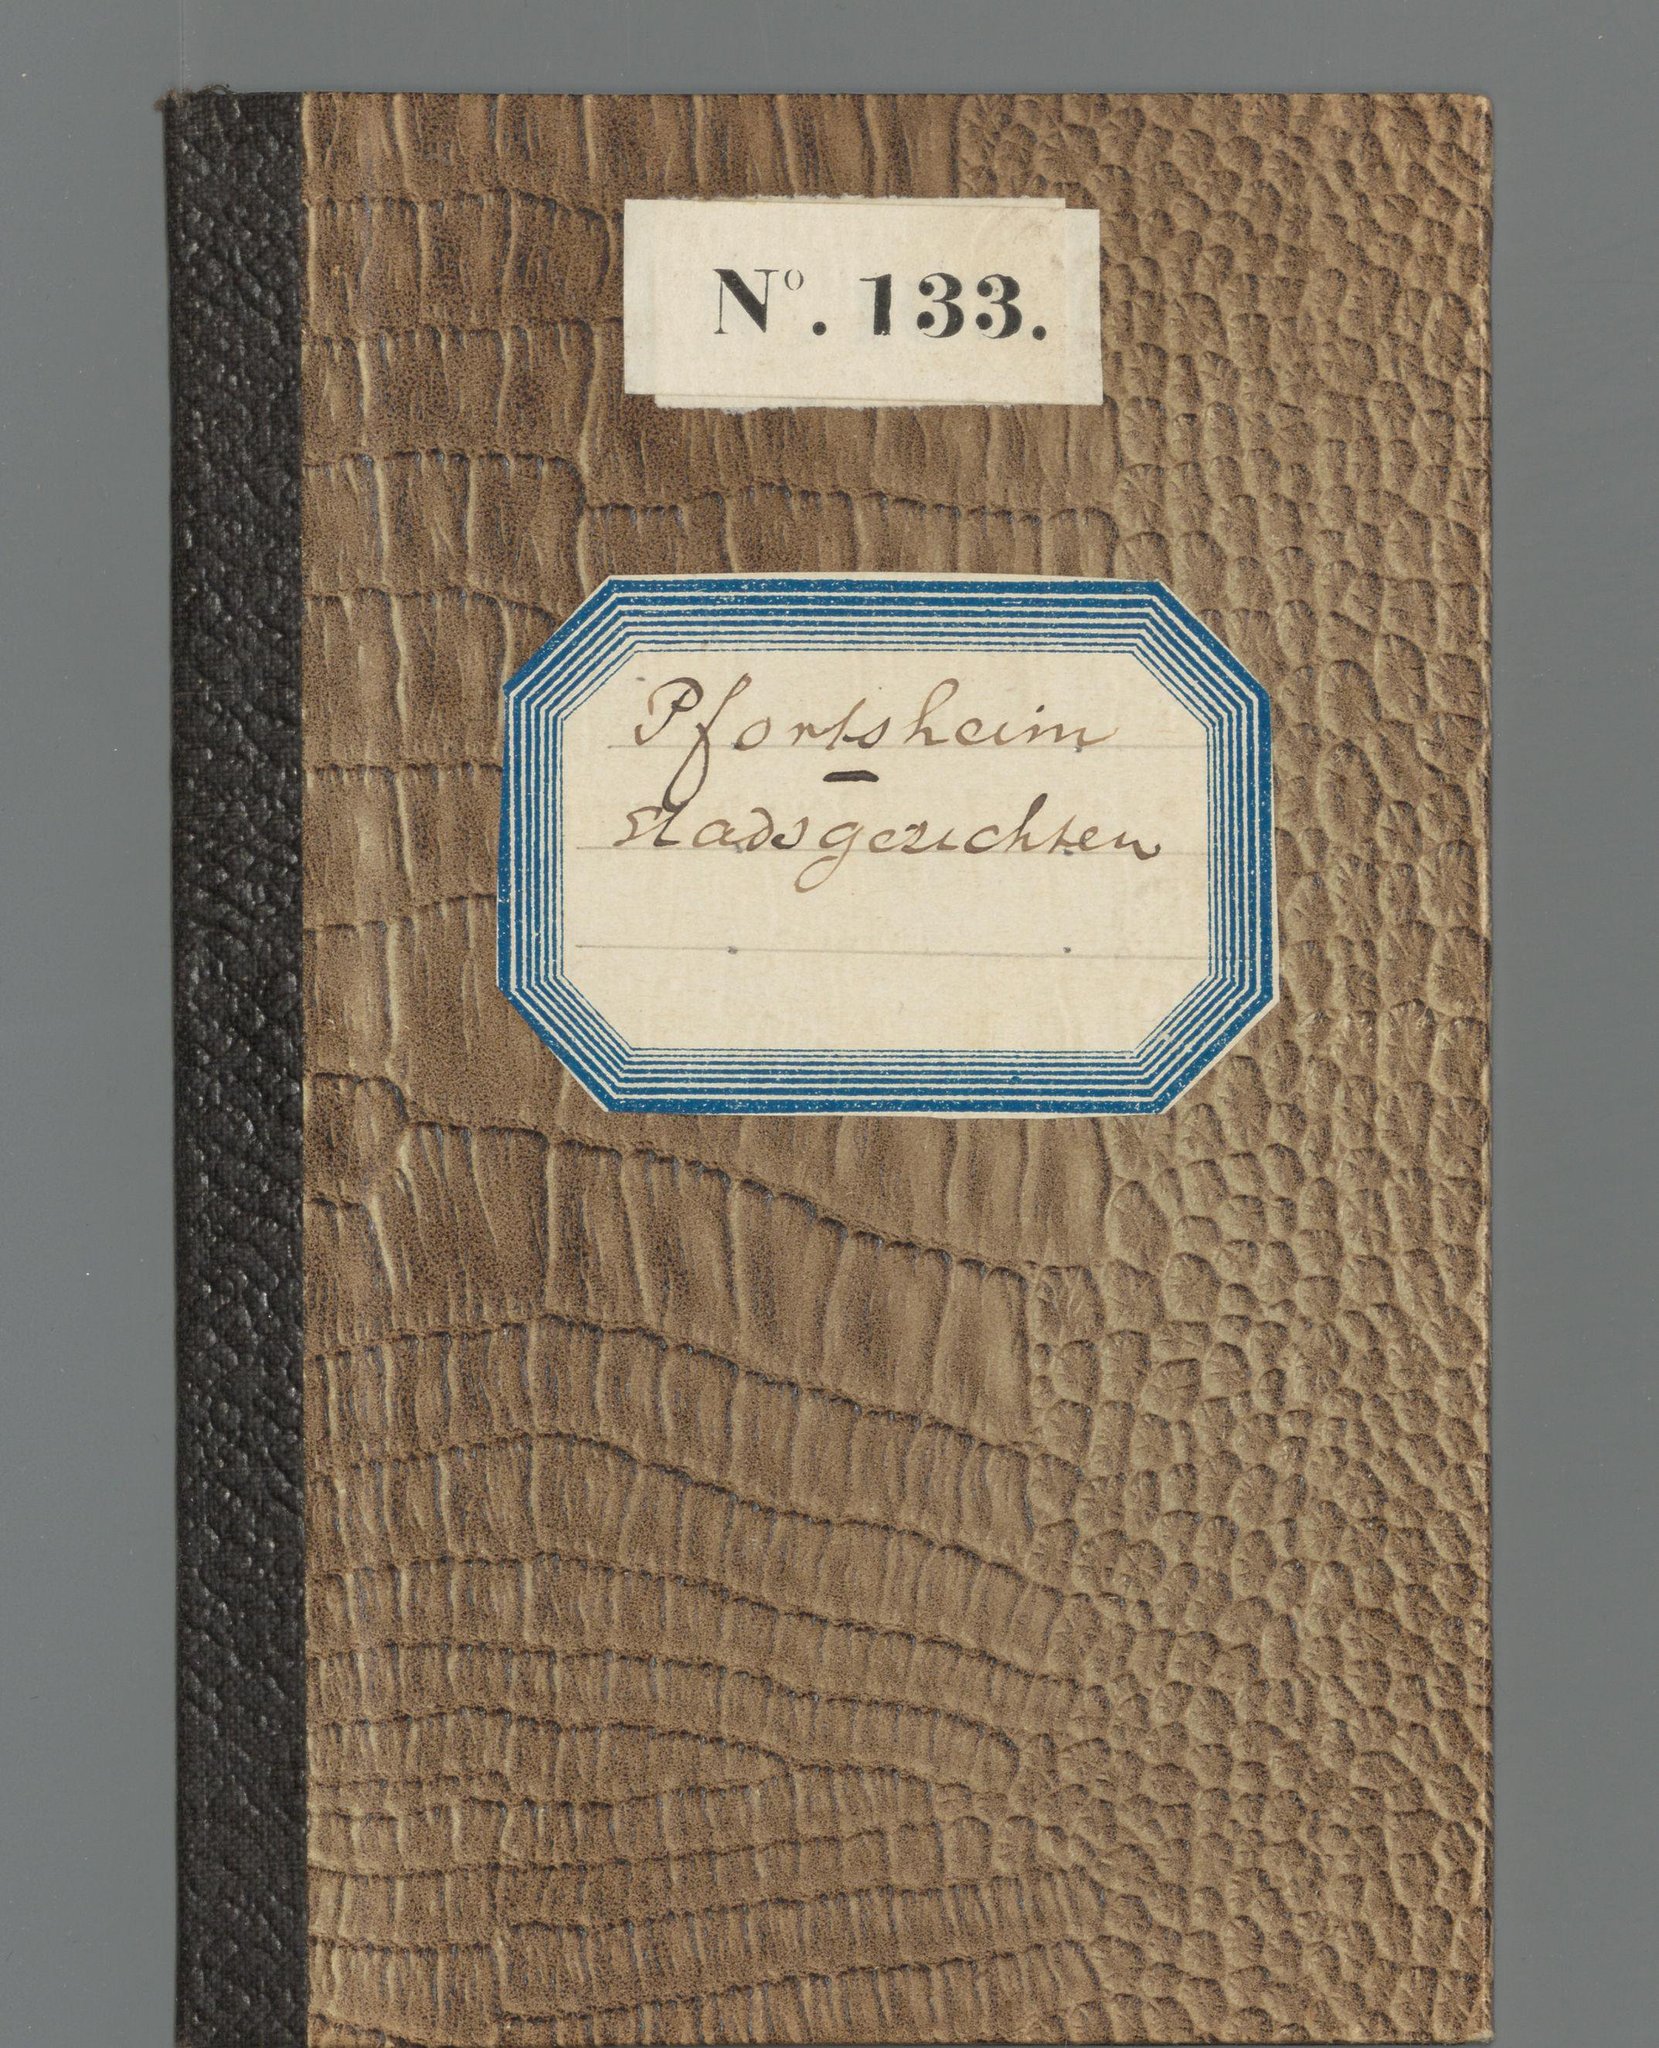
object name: wrapper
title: Pfortsheim. Stadsgezichten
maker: Anonymous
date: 1900-1950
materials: cardboard, paper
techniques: lithograph, writing